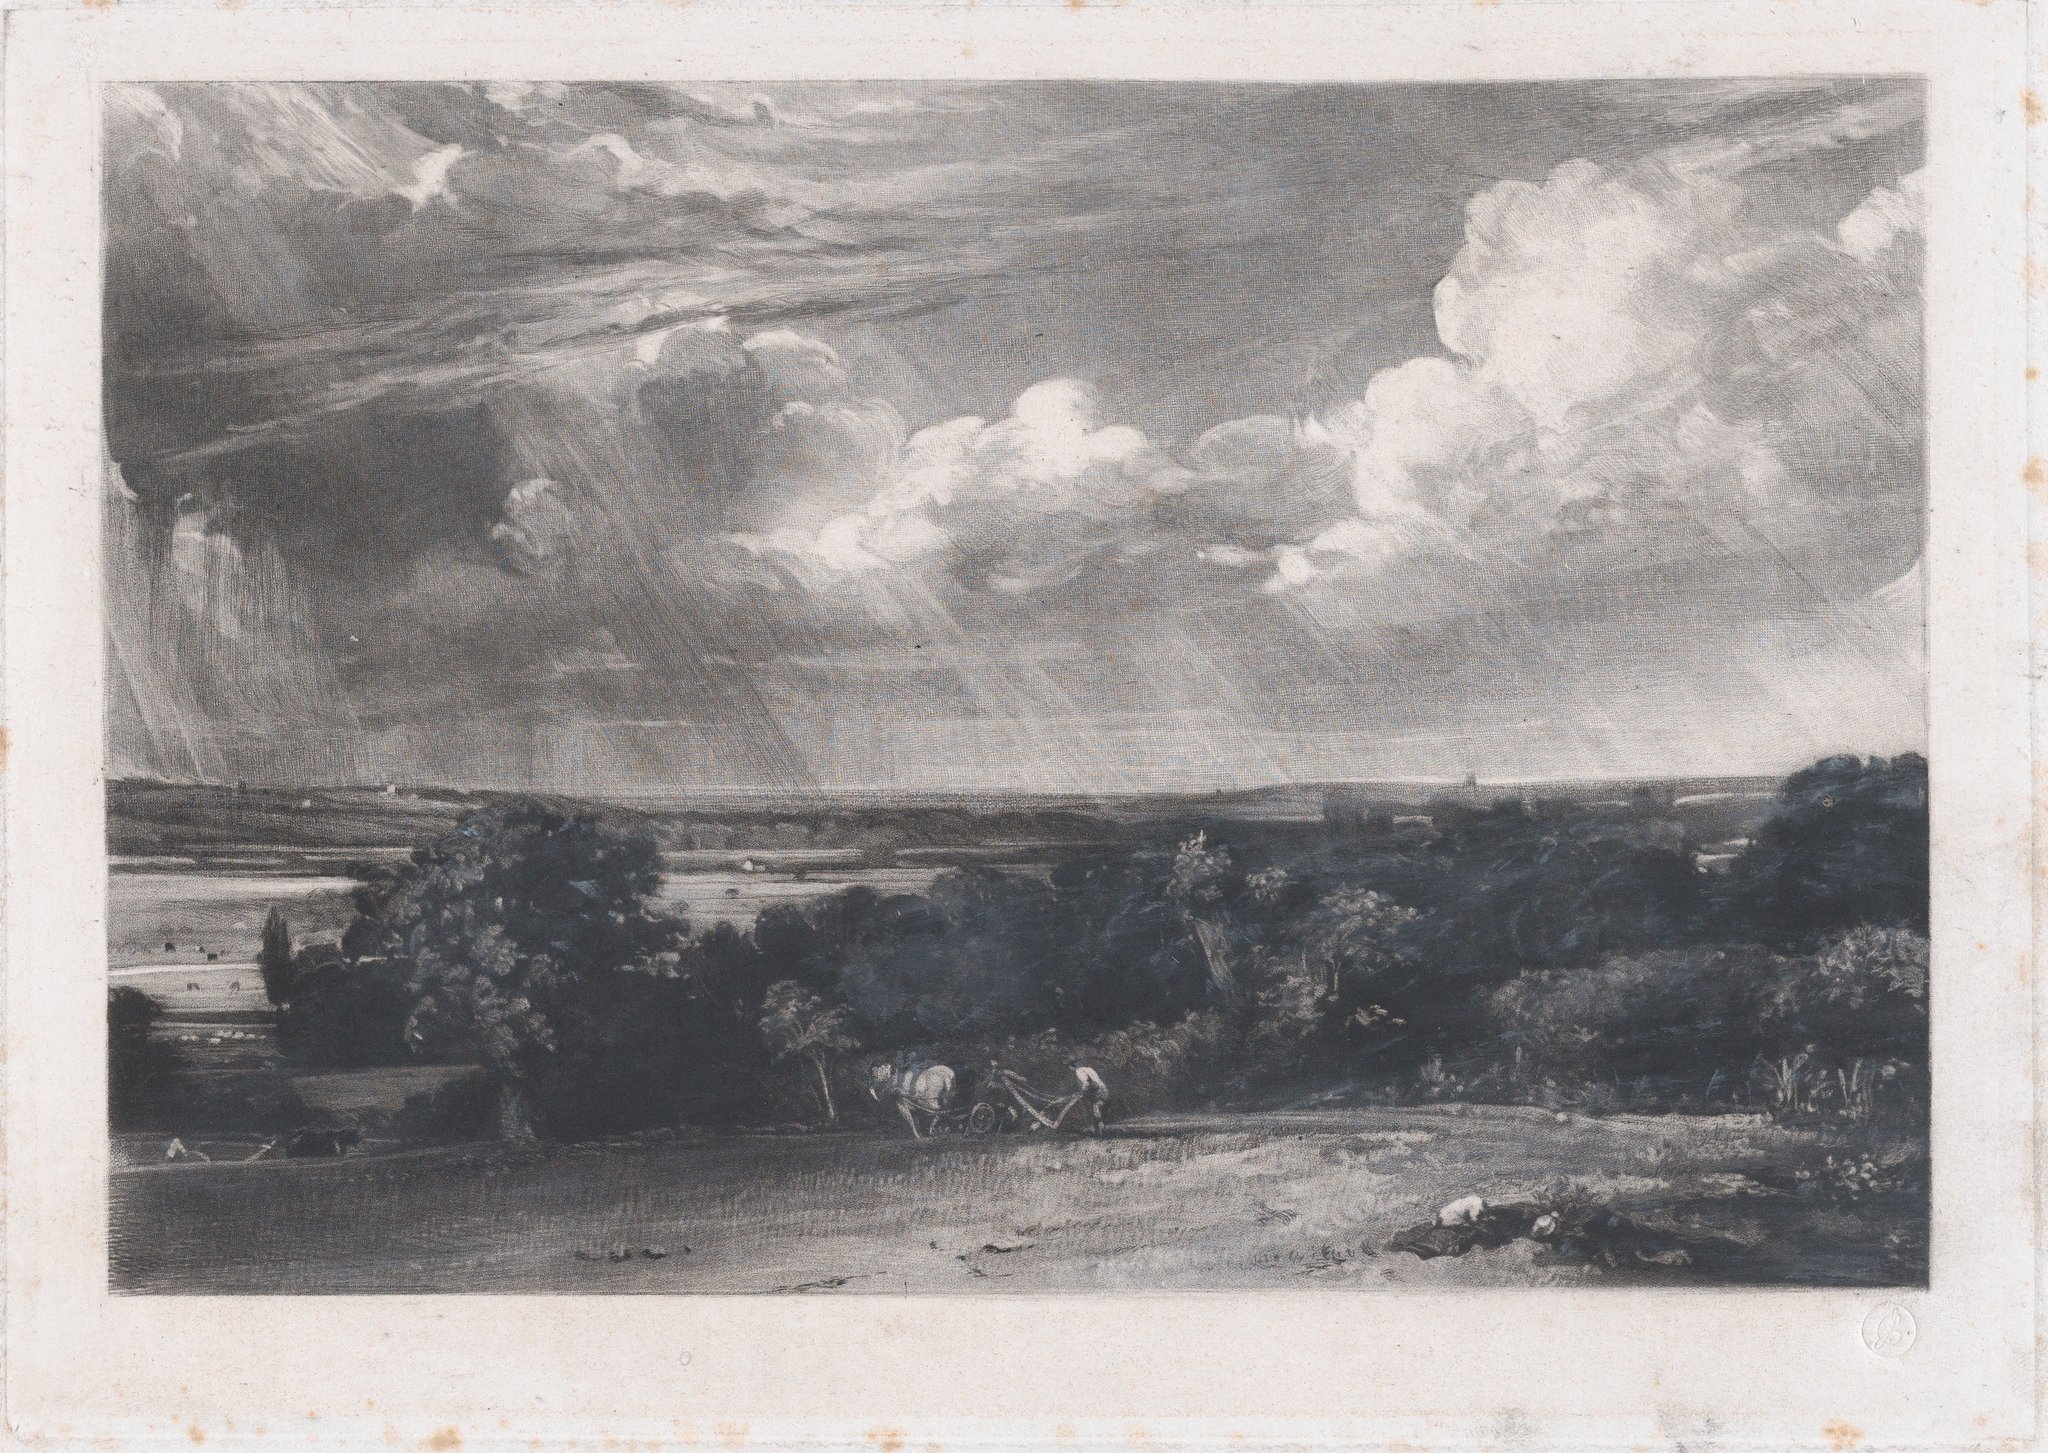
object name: print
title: A Summerland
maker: david lucas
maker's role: artist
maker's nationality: british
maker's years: 1802-1881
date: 1829-1831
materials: chalk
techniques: drypoint, mezzotint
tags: animals,men,landscapes,trees,working